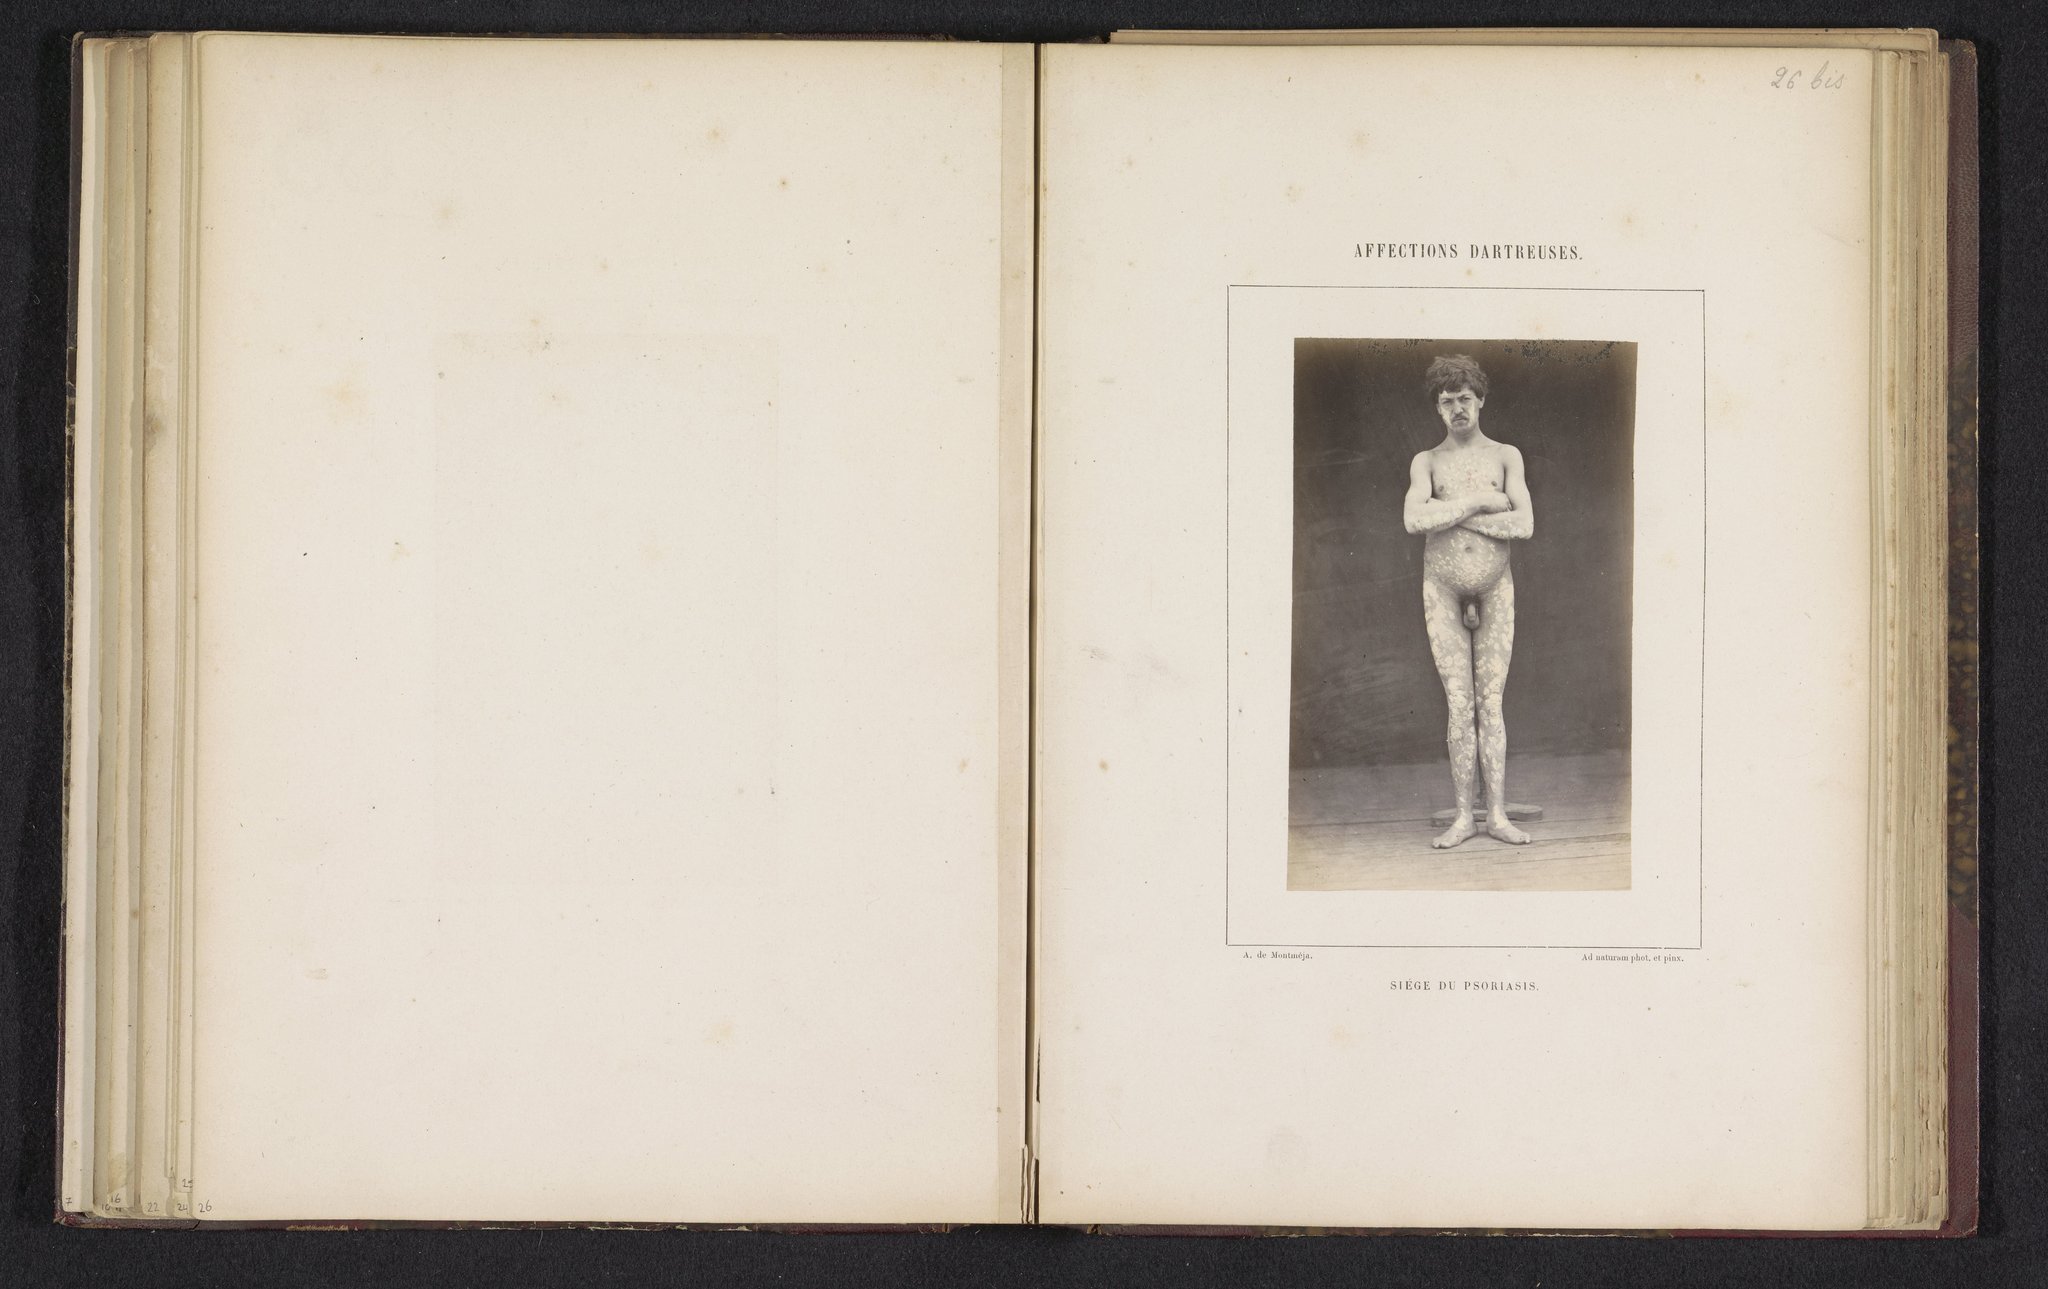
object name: photograph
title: Portret van een onbekende man die lijdt aan psoriasis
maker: a. de montméja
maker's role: arts, fotograaf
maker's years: 1841-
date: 1860-1868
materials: photographic support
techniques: albumen print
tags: skin and venereal diseases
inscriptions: number: ‘26 bis’, inscription: ‘Affections dartreuses’, inscription: ‘Ad naturam phot. et pinx.’